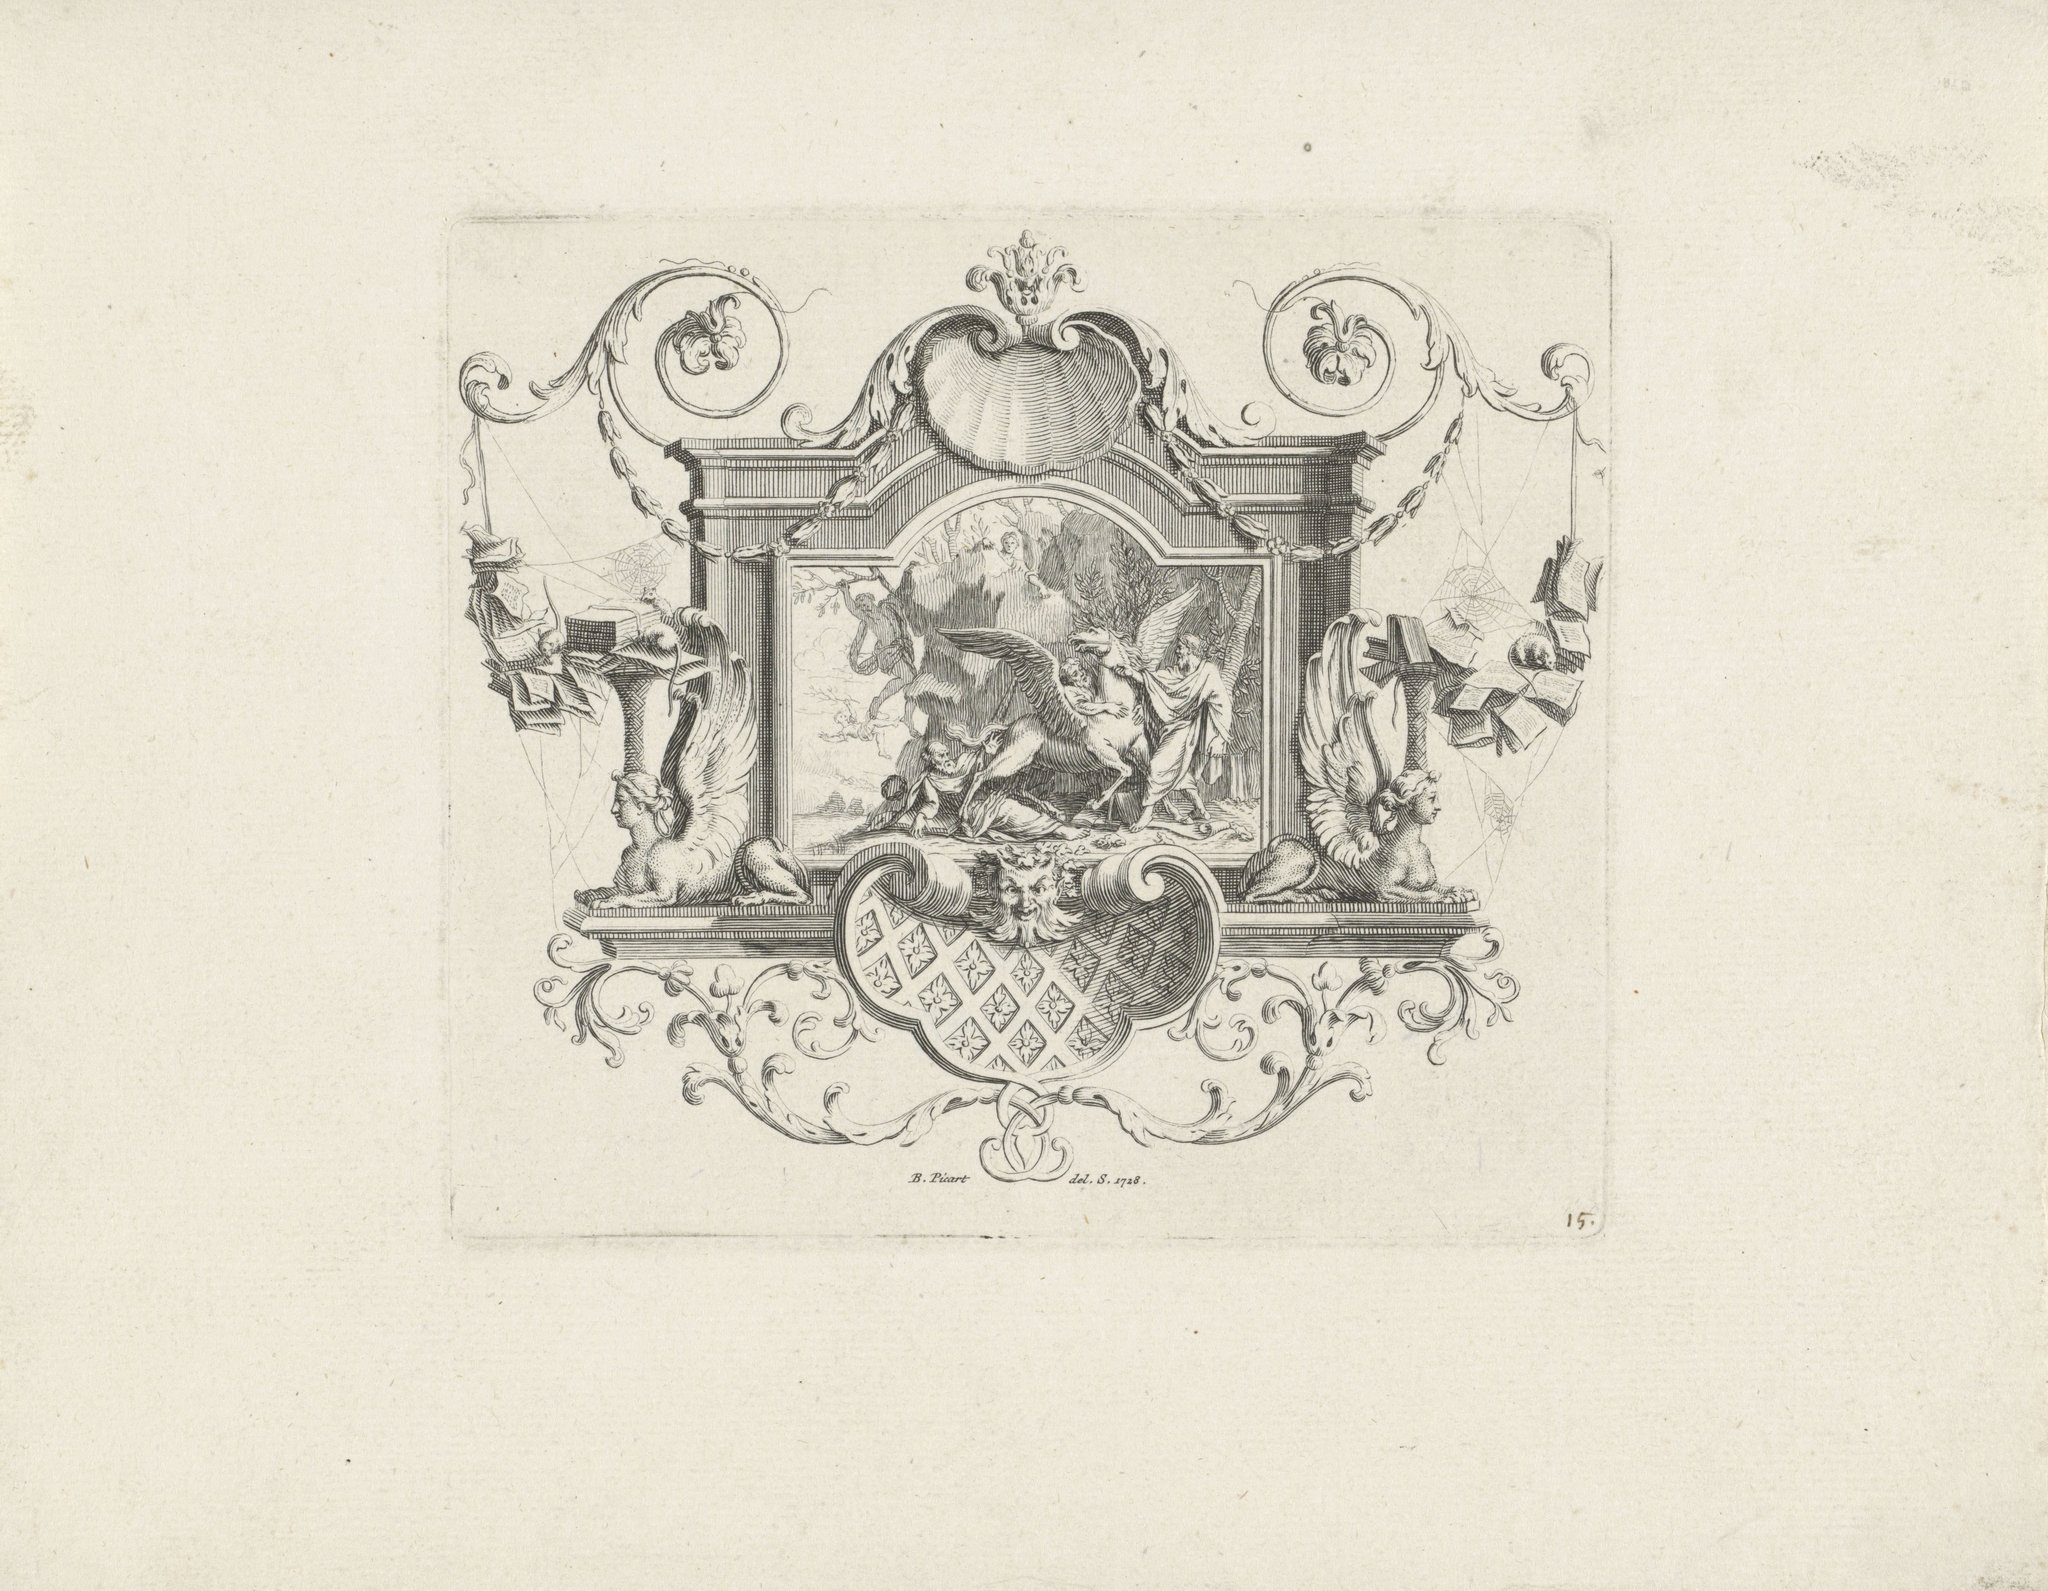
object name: print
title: Beteugelen van Pegasus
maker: bernard picart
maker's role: draughtsman, print maker, publisher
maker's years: 1673-1733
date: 1728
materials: paper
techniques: engraving, etching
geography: amsterdam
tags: pegasus, the winged horse, ornaments ~ art, writer, poet, author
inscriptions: collector's mark: Lugt 2760, number: ‘15.’, collector's mark: Lugt 2228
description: Een aantal dichters en schrijvers proberen Pegasus te beteugelen. Op de achtergrond proberen dichters en schrijvers de Parnassus te beklimmen. De voorstelling is gevat in een ornamentele lijst versierd met bladranken, rolwerk, sfinxen, draken, spinnewebben, boeken, een schelp en een mascaron.